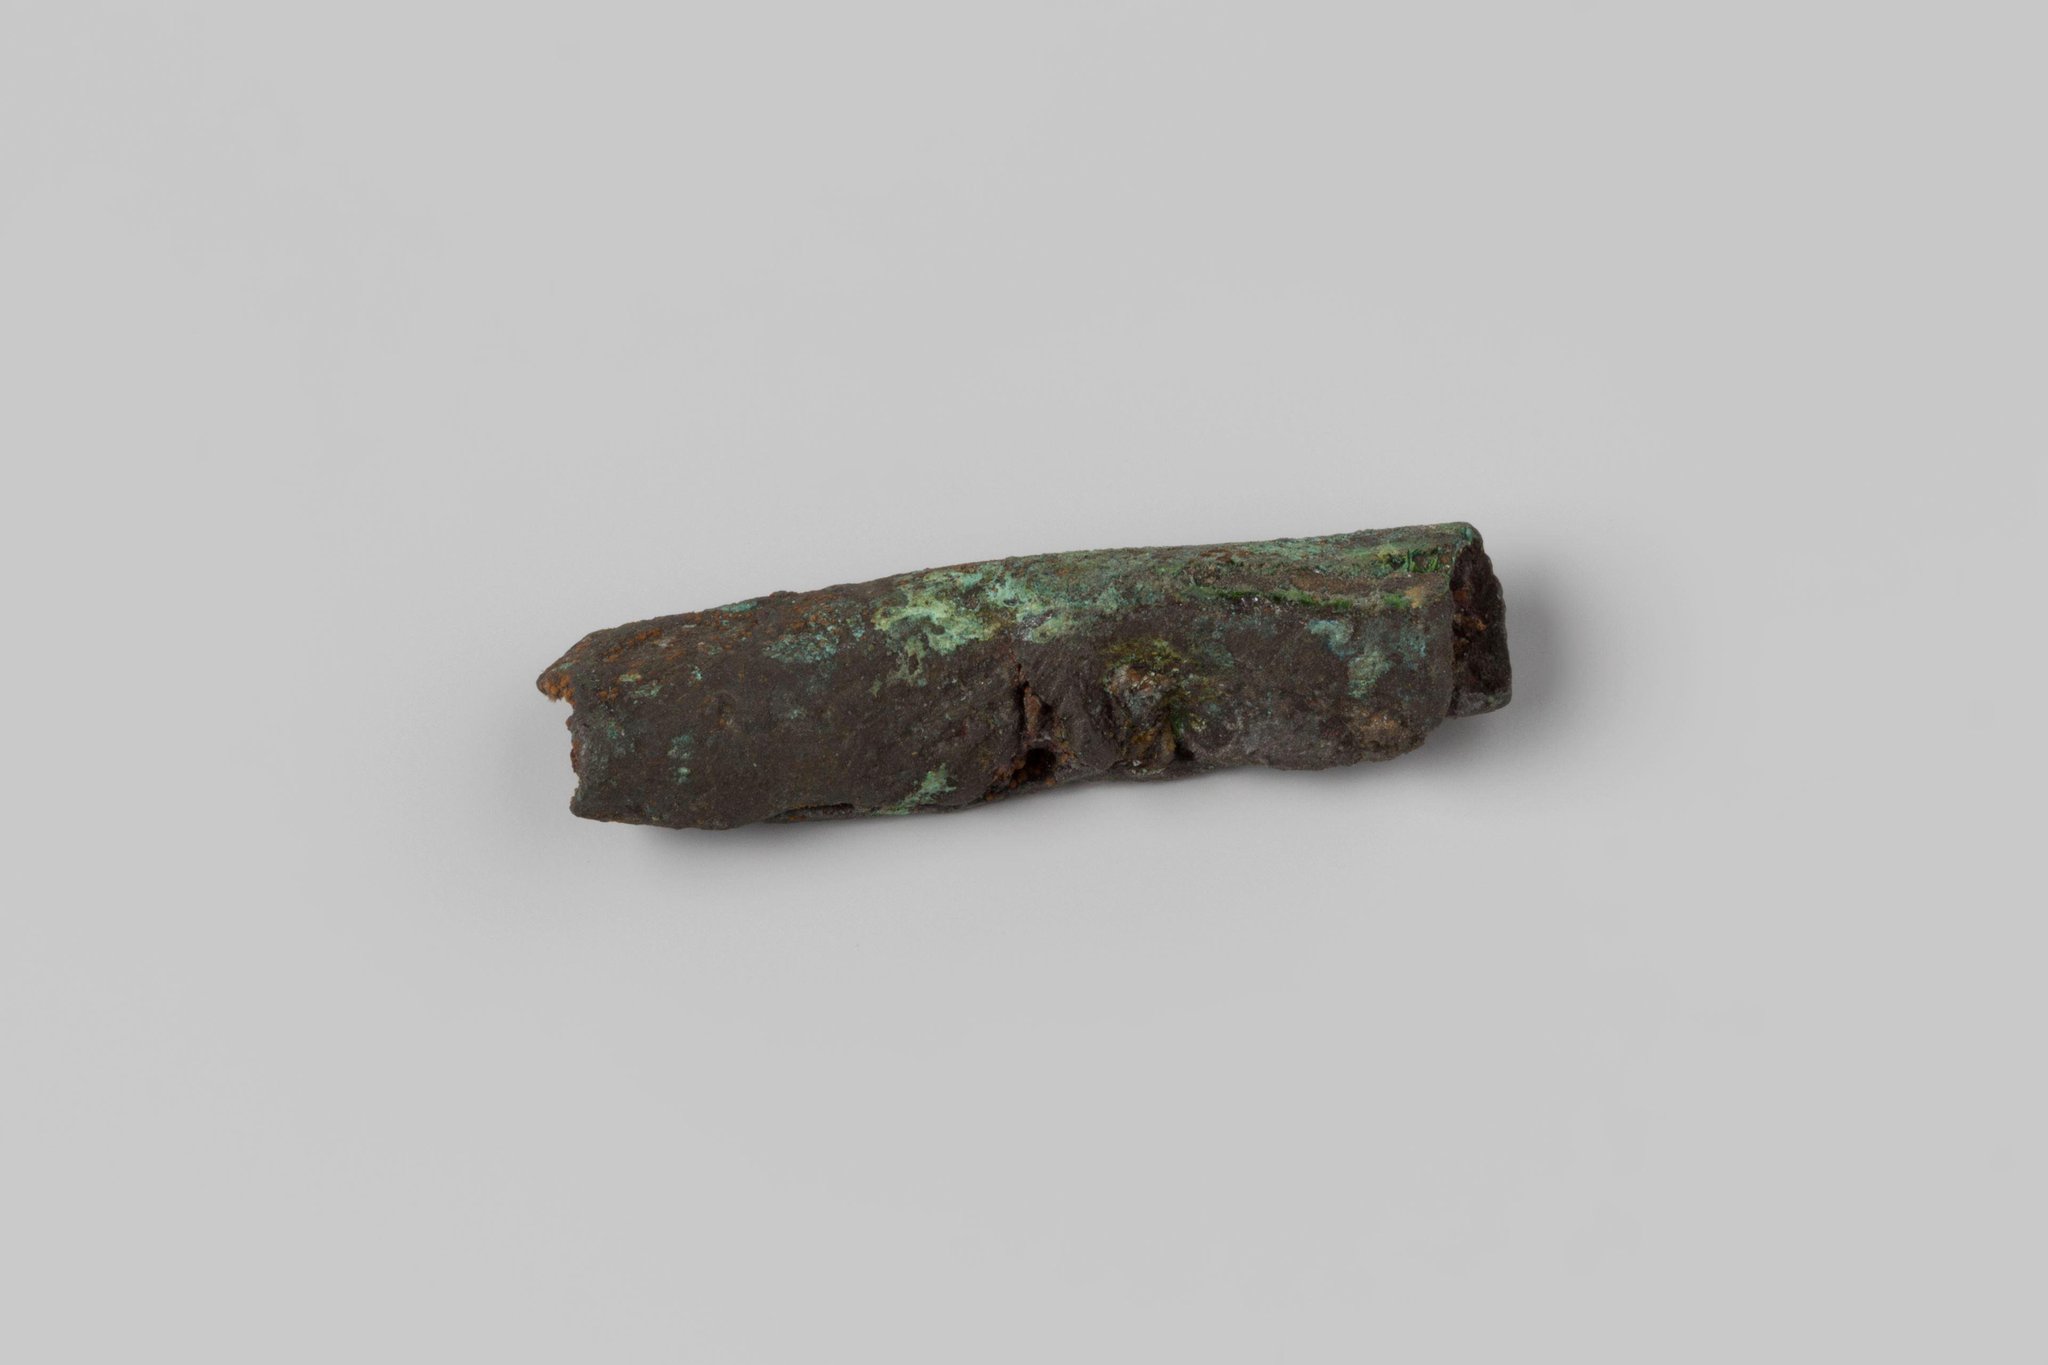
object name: scheepswrakvondst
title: Fragment van koper uit het wrak van de Oost-Indiëvaarder Hollandia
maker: Anonymous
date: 1700-1743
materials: copper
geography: netherlands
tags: verenigde oostindische compagnie, hollandia (schip), annet